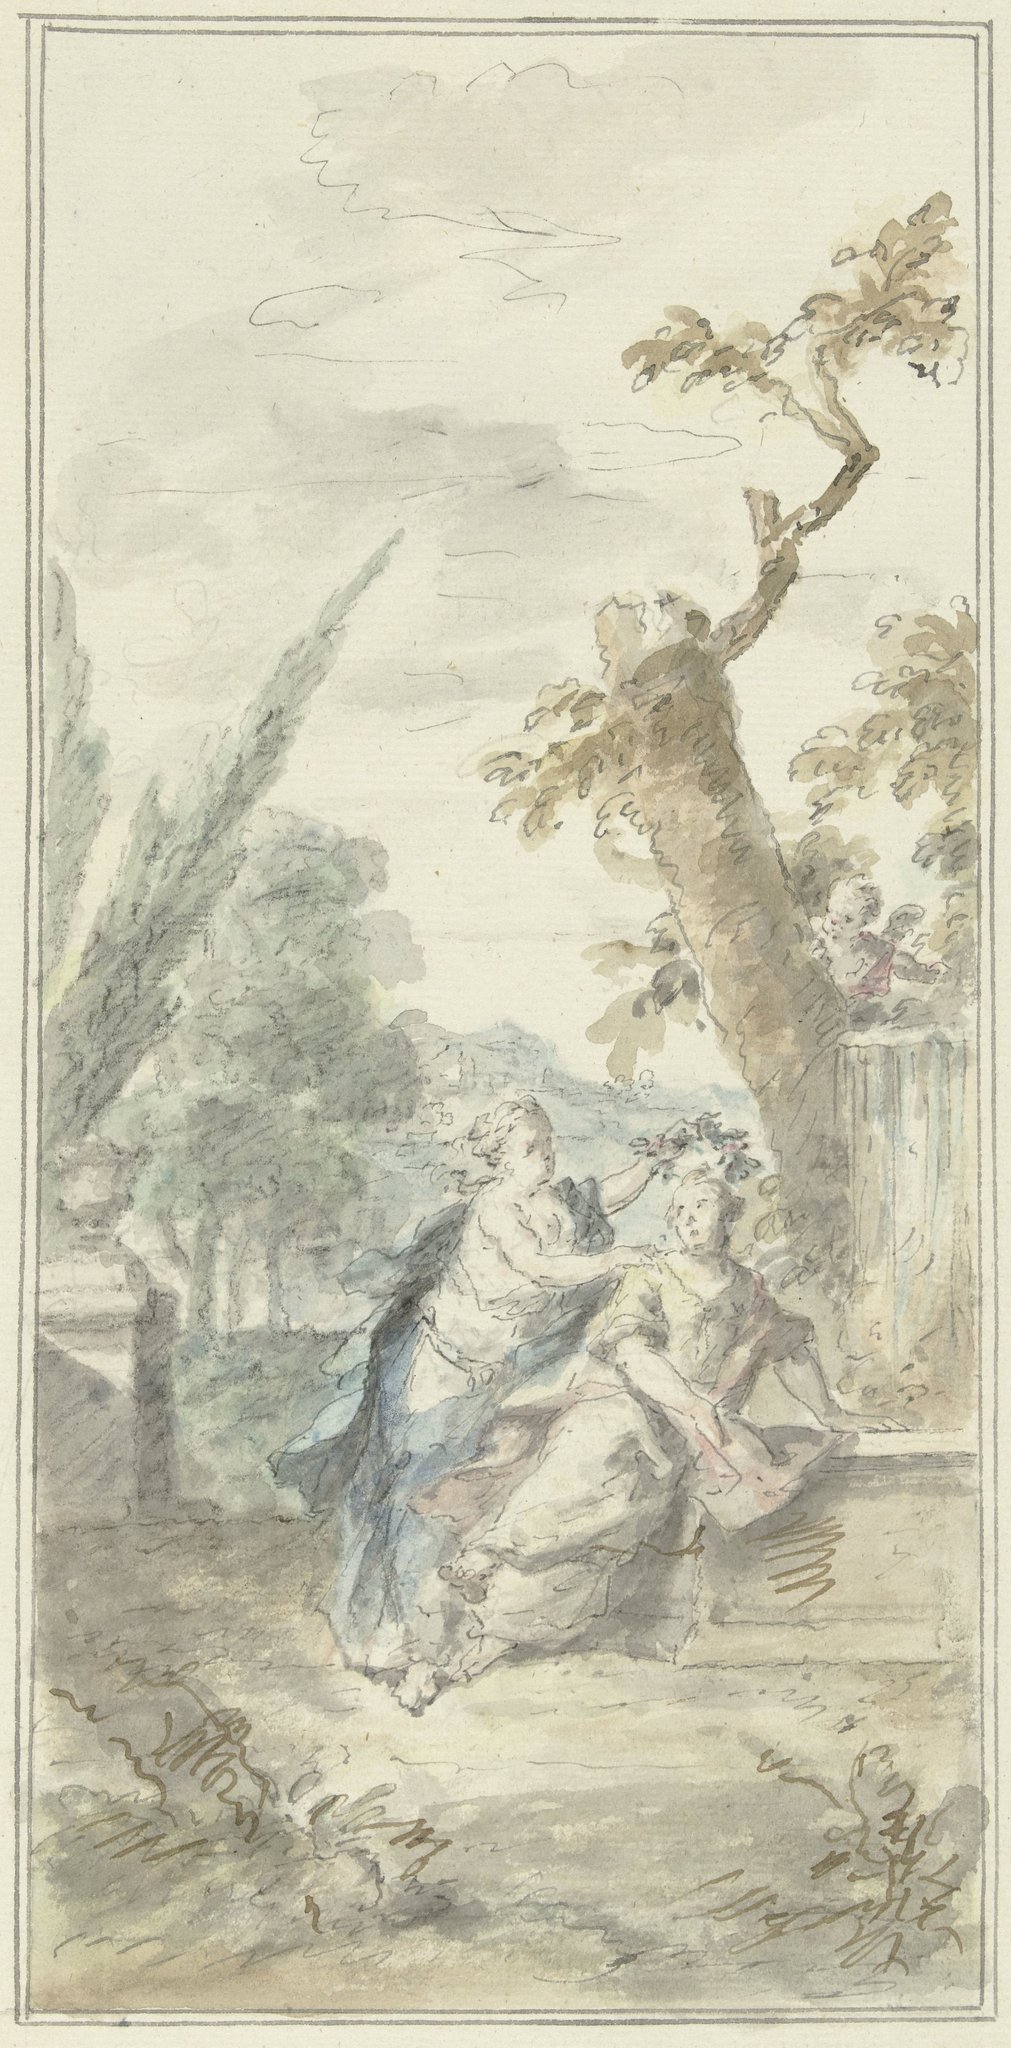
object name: watercolor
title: Ontwerp voor een zaalstuk: Amaryllis kroont Myrtillo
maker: dionys van nijmegen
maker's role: draughtsman, painter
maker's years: 1705-1798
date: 1715-1798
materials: ink, paper, pencil, watercolor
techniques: brush, pen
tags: (scenes from) specific works of literature: guarini, pastor fido